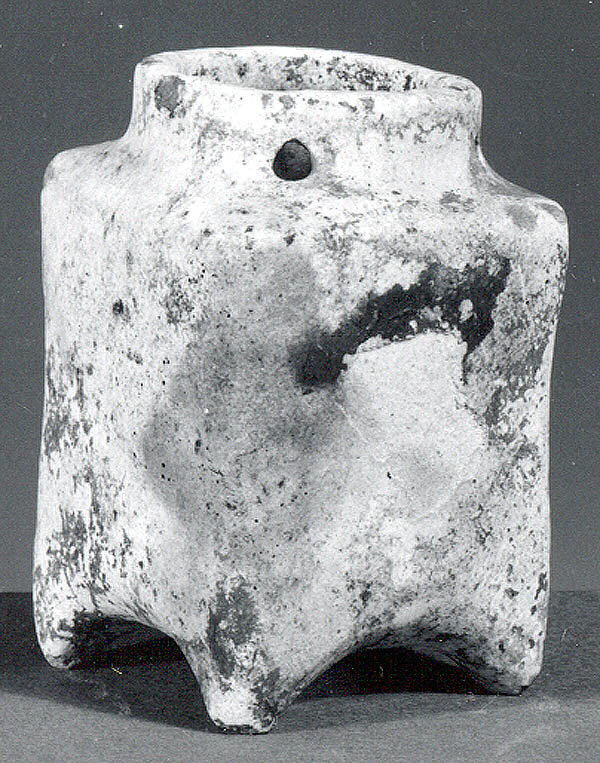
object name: jar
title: Square jar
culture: iranian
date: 900-801 BCE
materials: faience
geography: iran